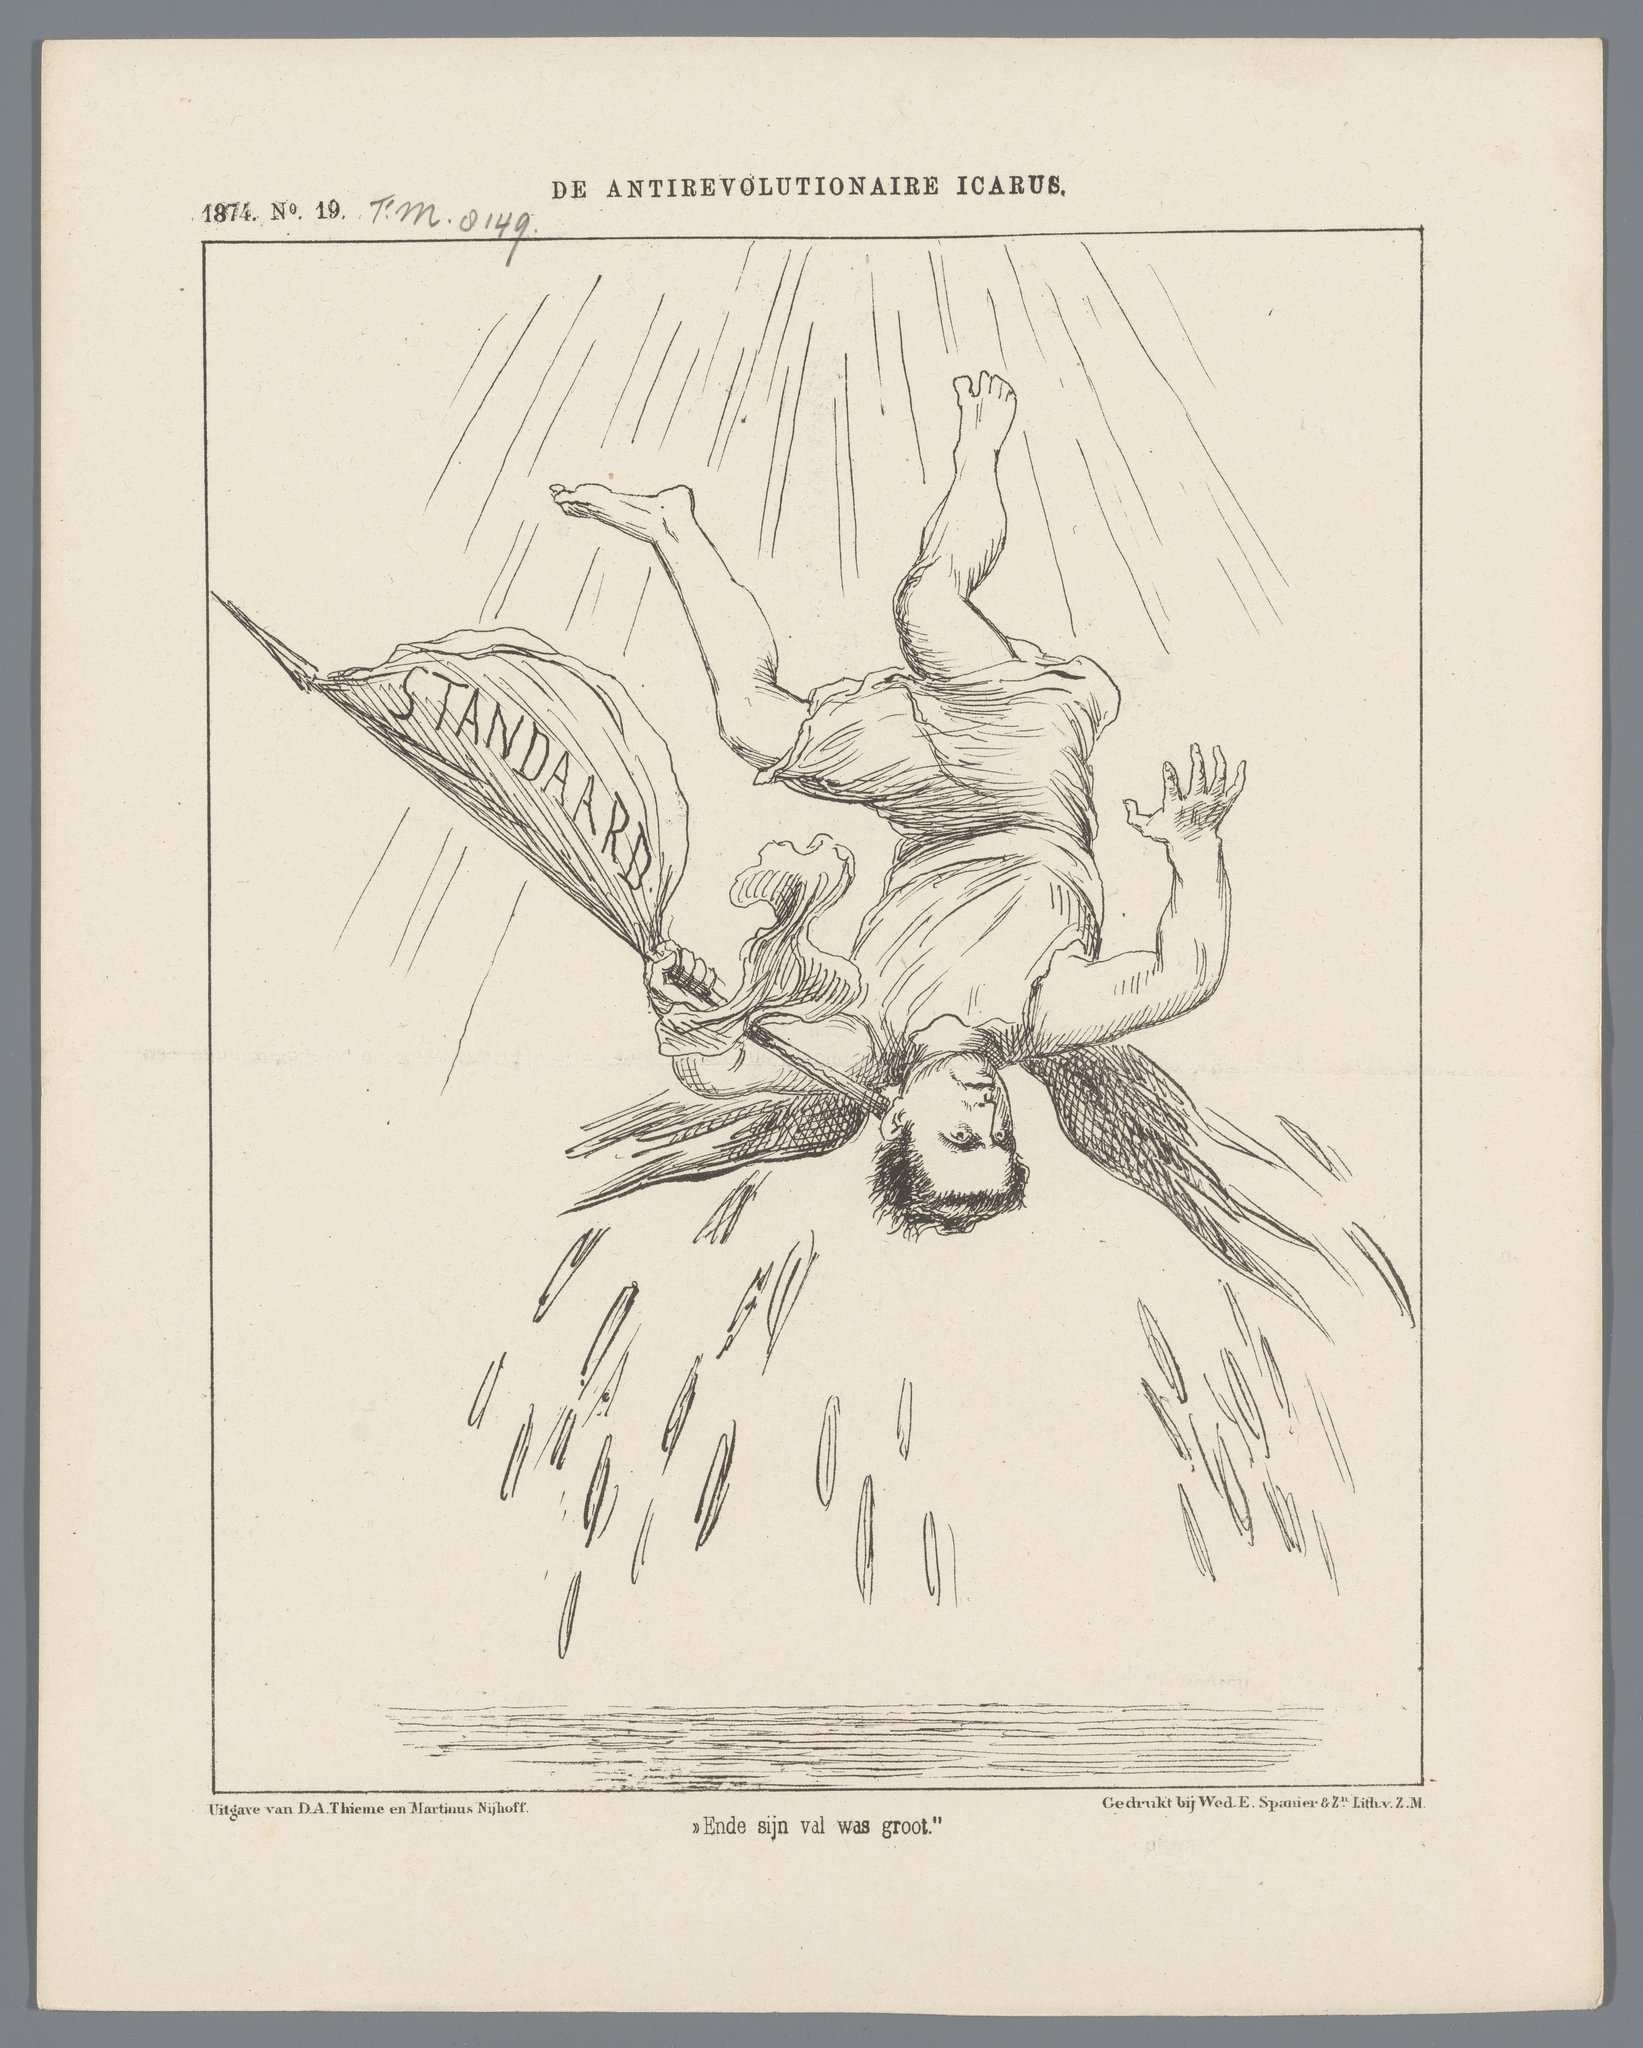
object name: cartoon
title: De Antirevolutionaire Icarus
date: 1874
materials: paper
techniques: lithograph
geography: arnhem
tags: abraham kuyper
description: Spotprent op de geringe steun in de Tweede Kamer voor het amendement van Abraham Kuyper betreffende Kinderarbeid, 1874. Plaat verschenen bij het weekblad De Nederlandsche Spectator, nr. 19, 1874.